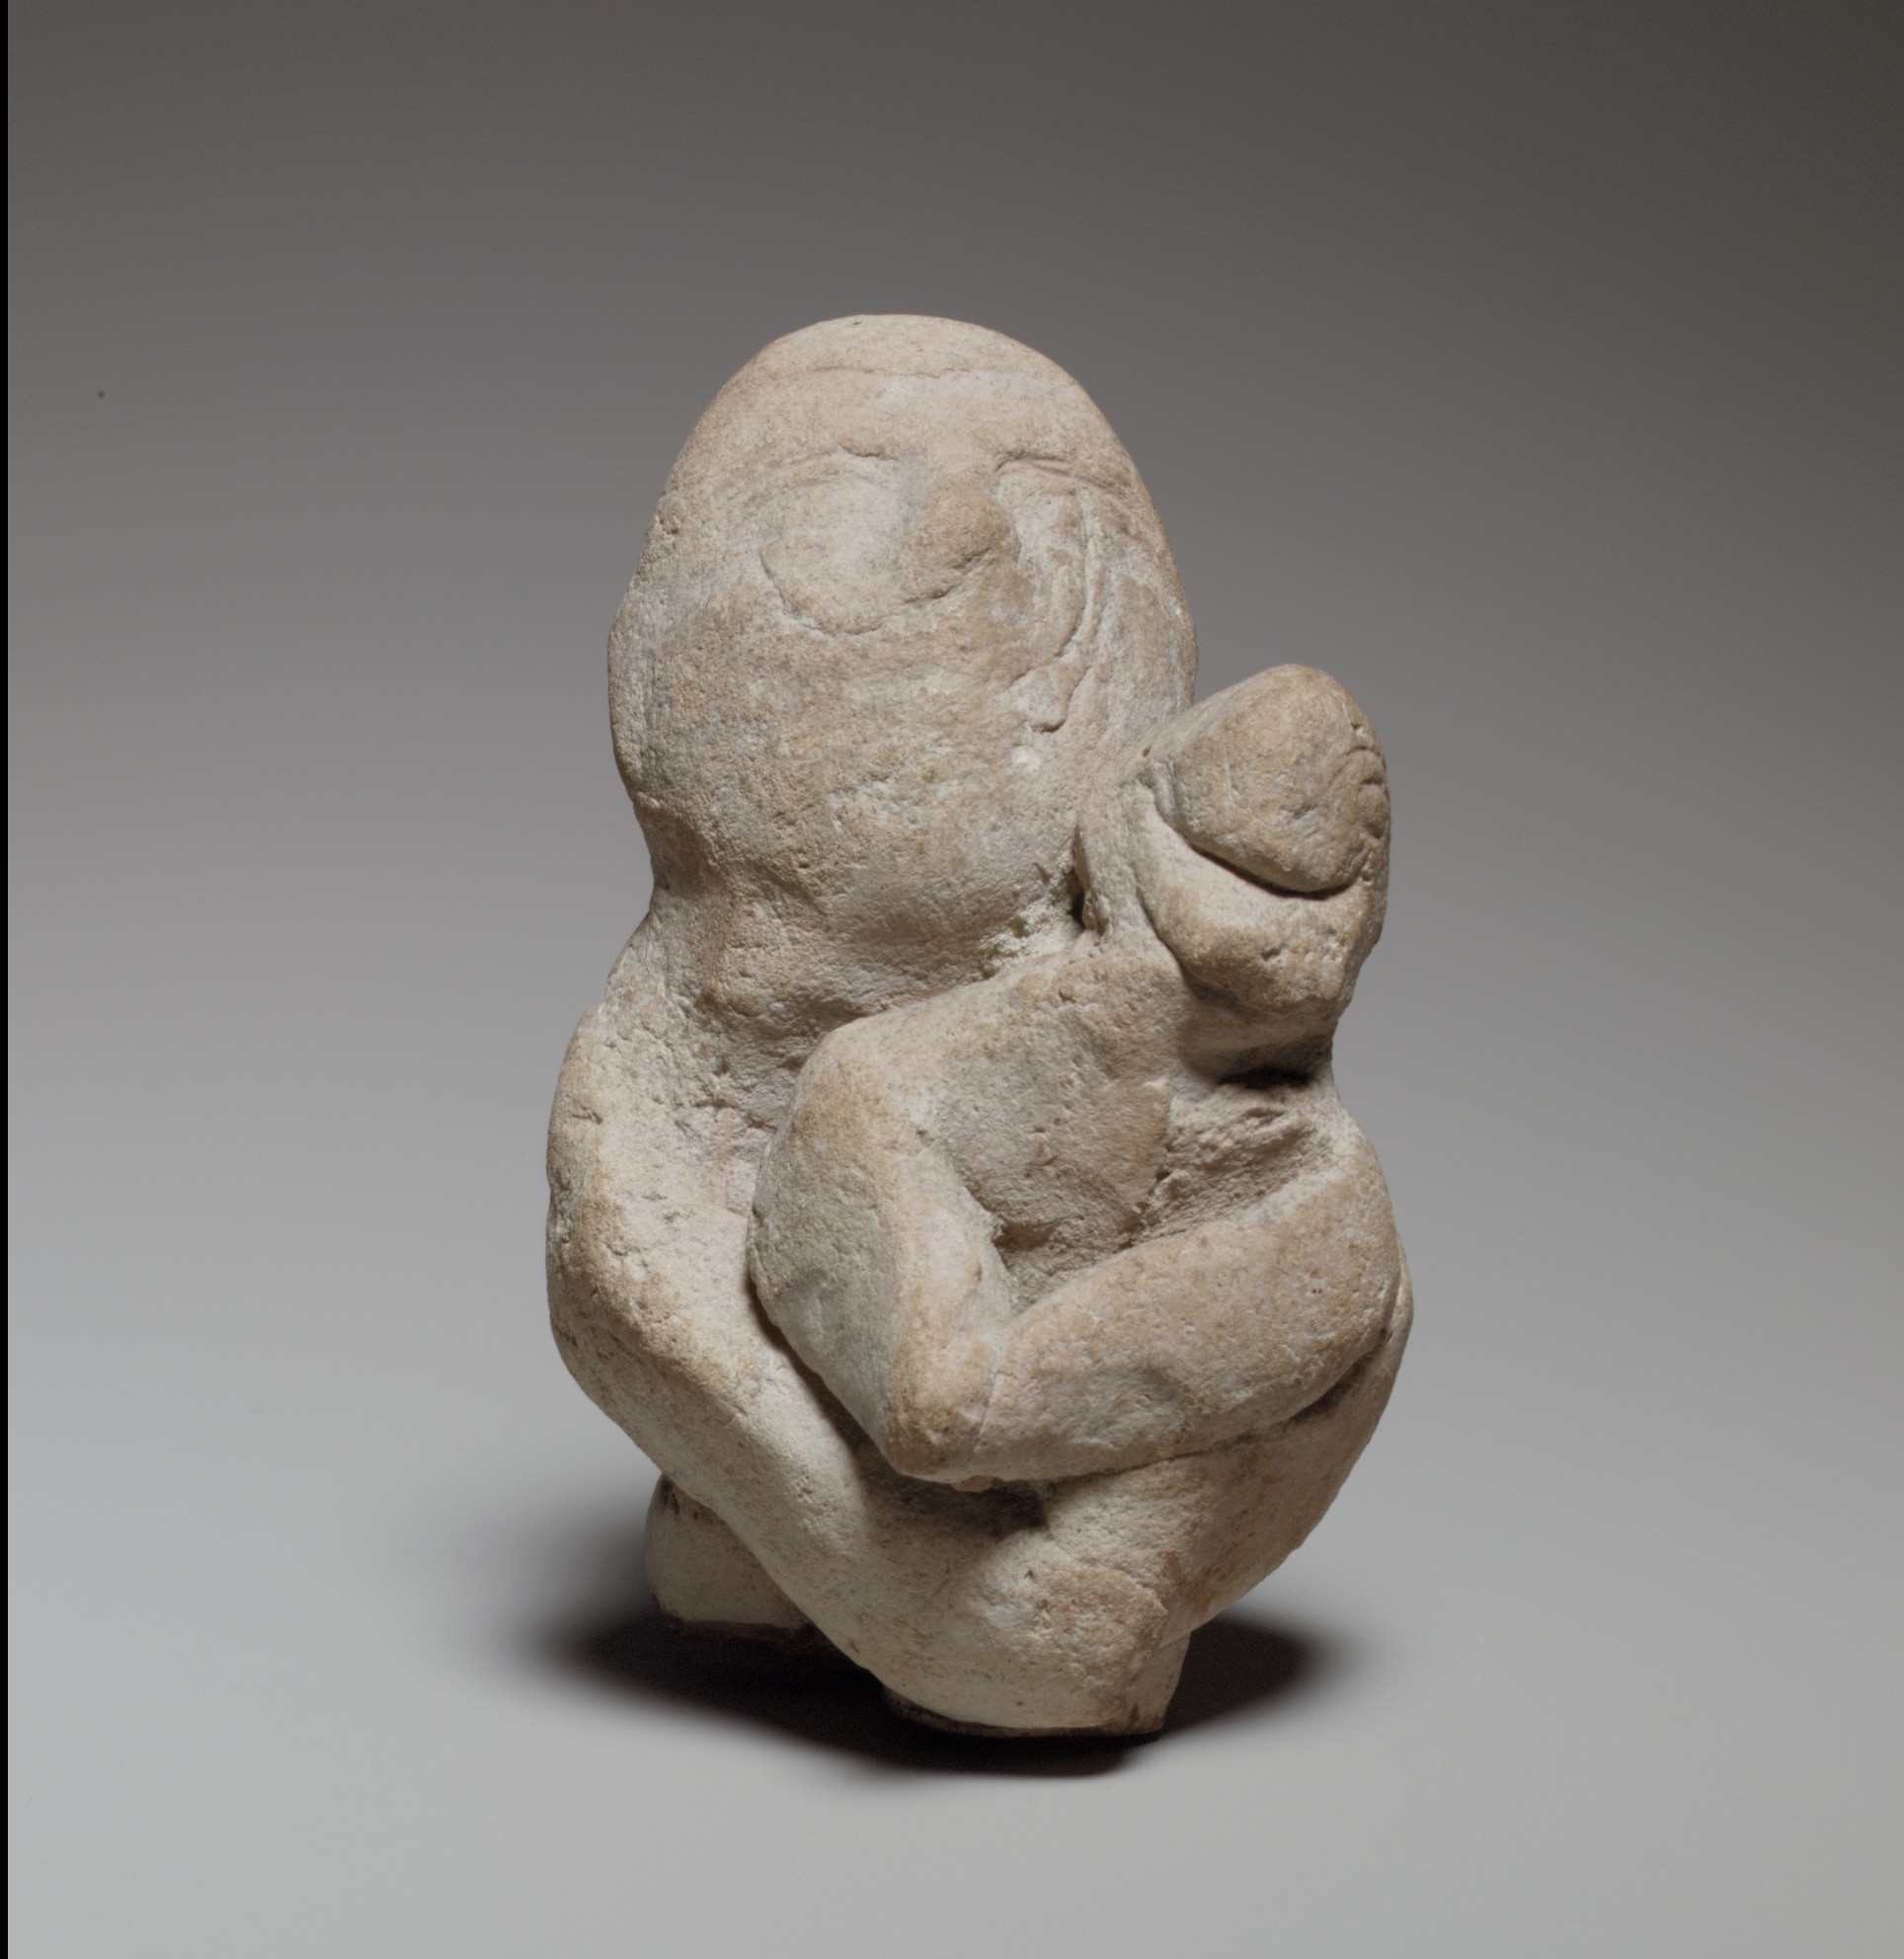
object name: statuette of a votary offering a child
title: Two figures in a scene of childbirth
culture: cypriot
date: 600-480 BCE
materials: terracotta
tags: women